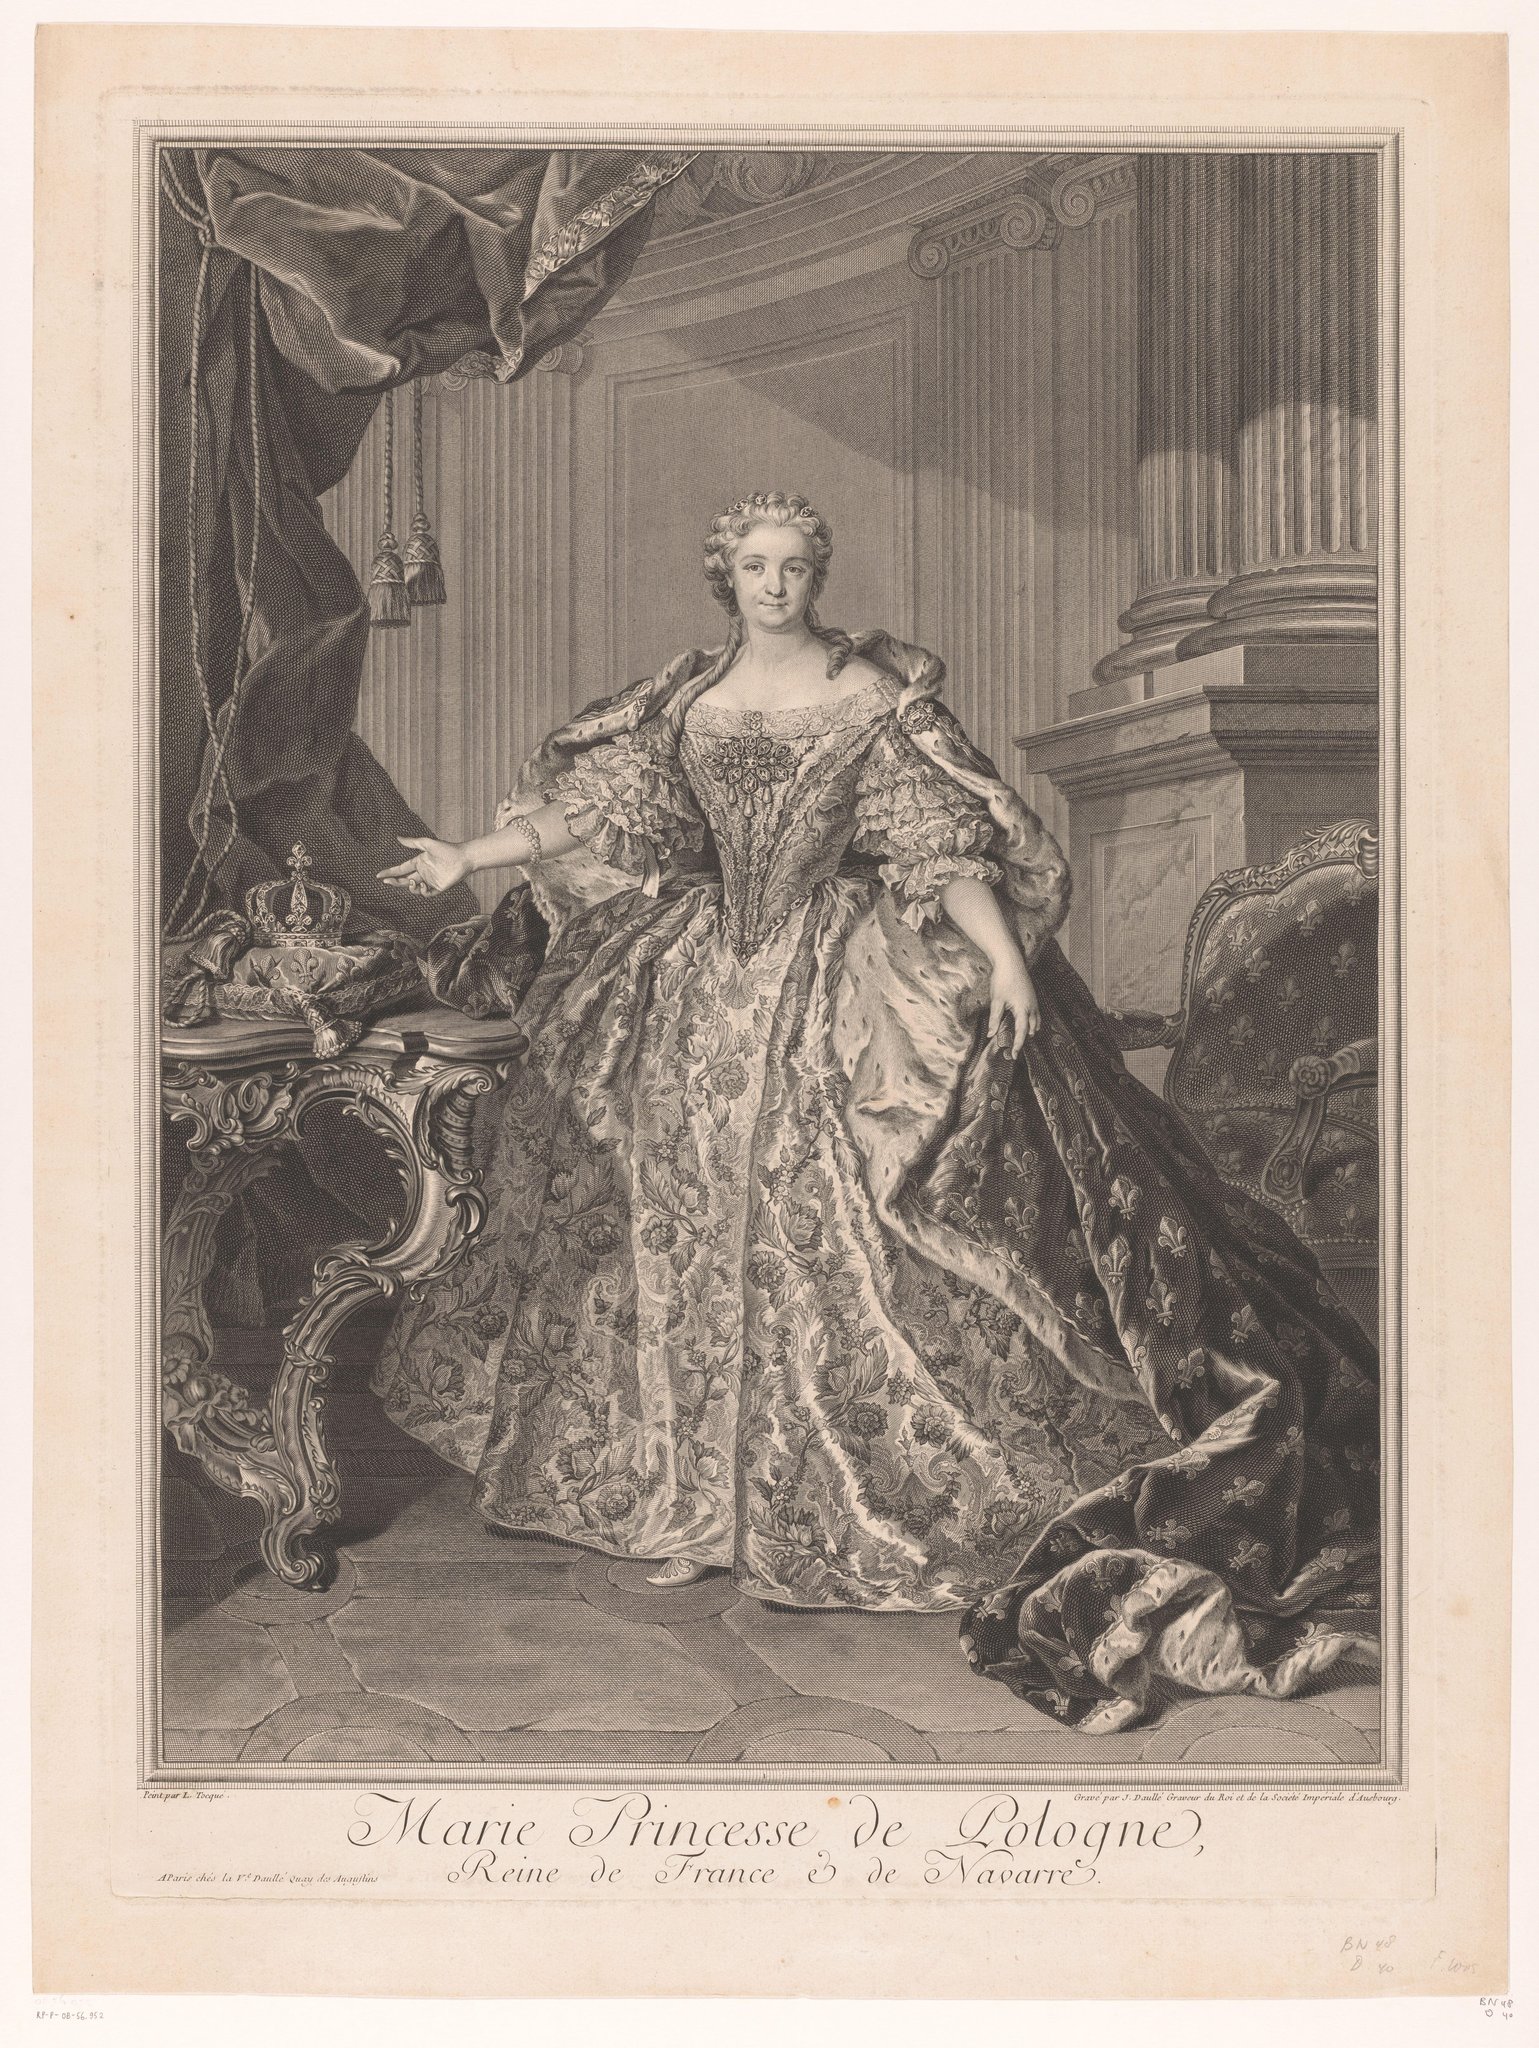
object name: print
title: Portret van Maria Leszczyńska, koningin van Frankrijk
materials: paper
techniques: engraving, etching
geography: paris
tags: maria lesczinska (koningin van frankrijk), historical persons - bb - woman, queen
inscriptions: collector's mark: Lugt 240